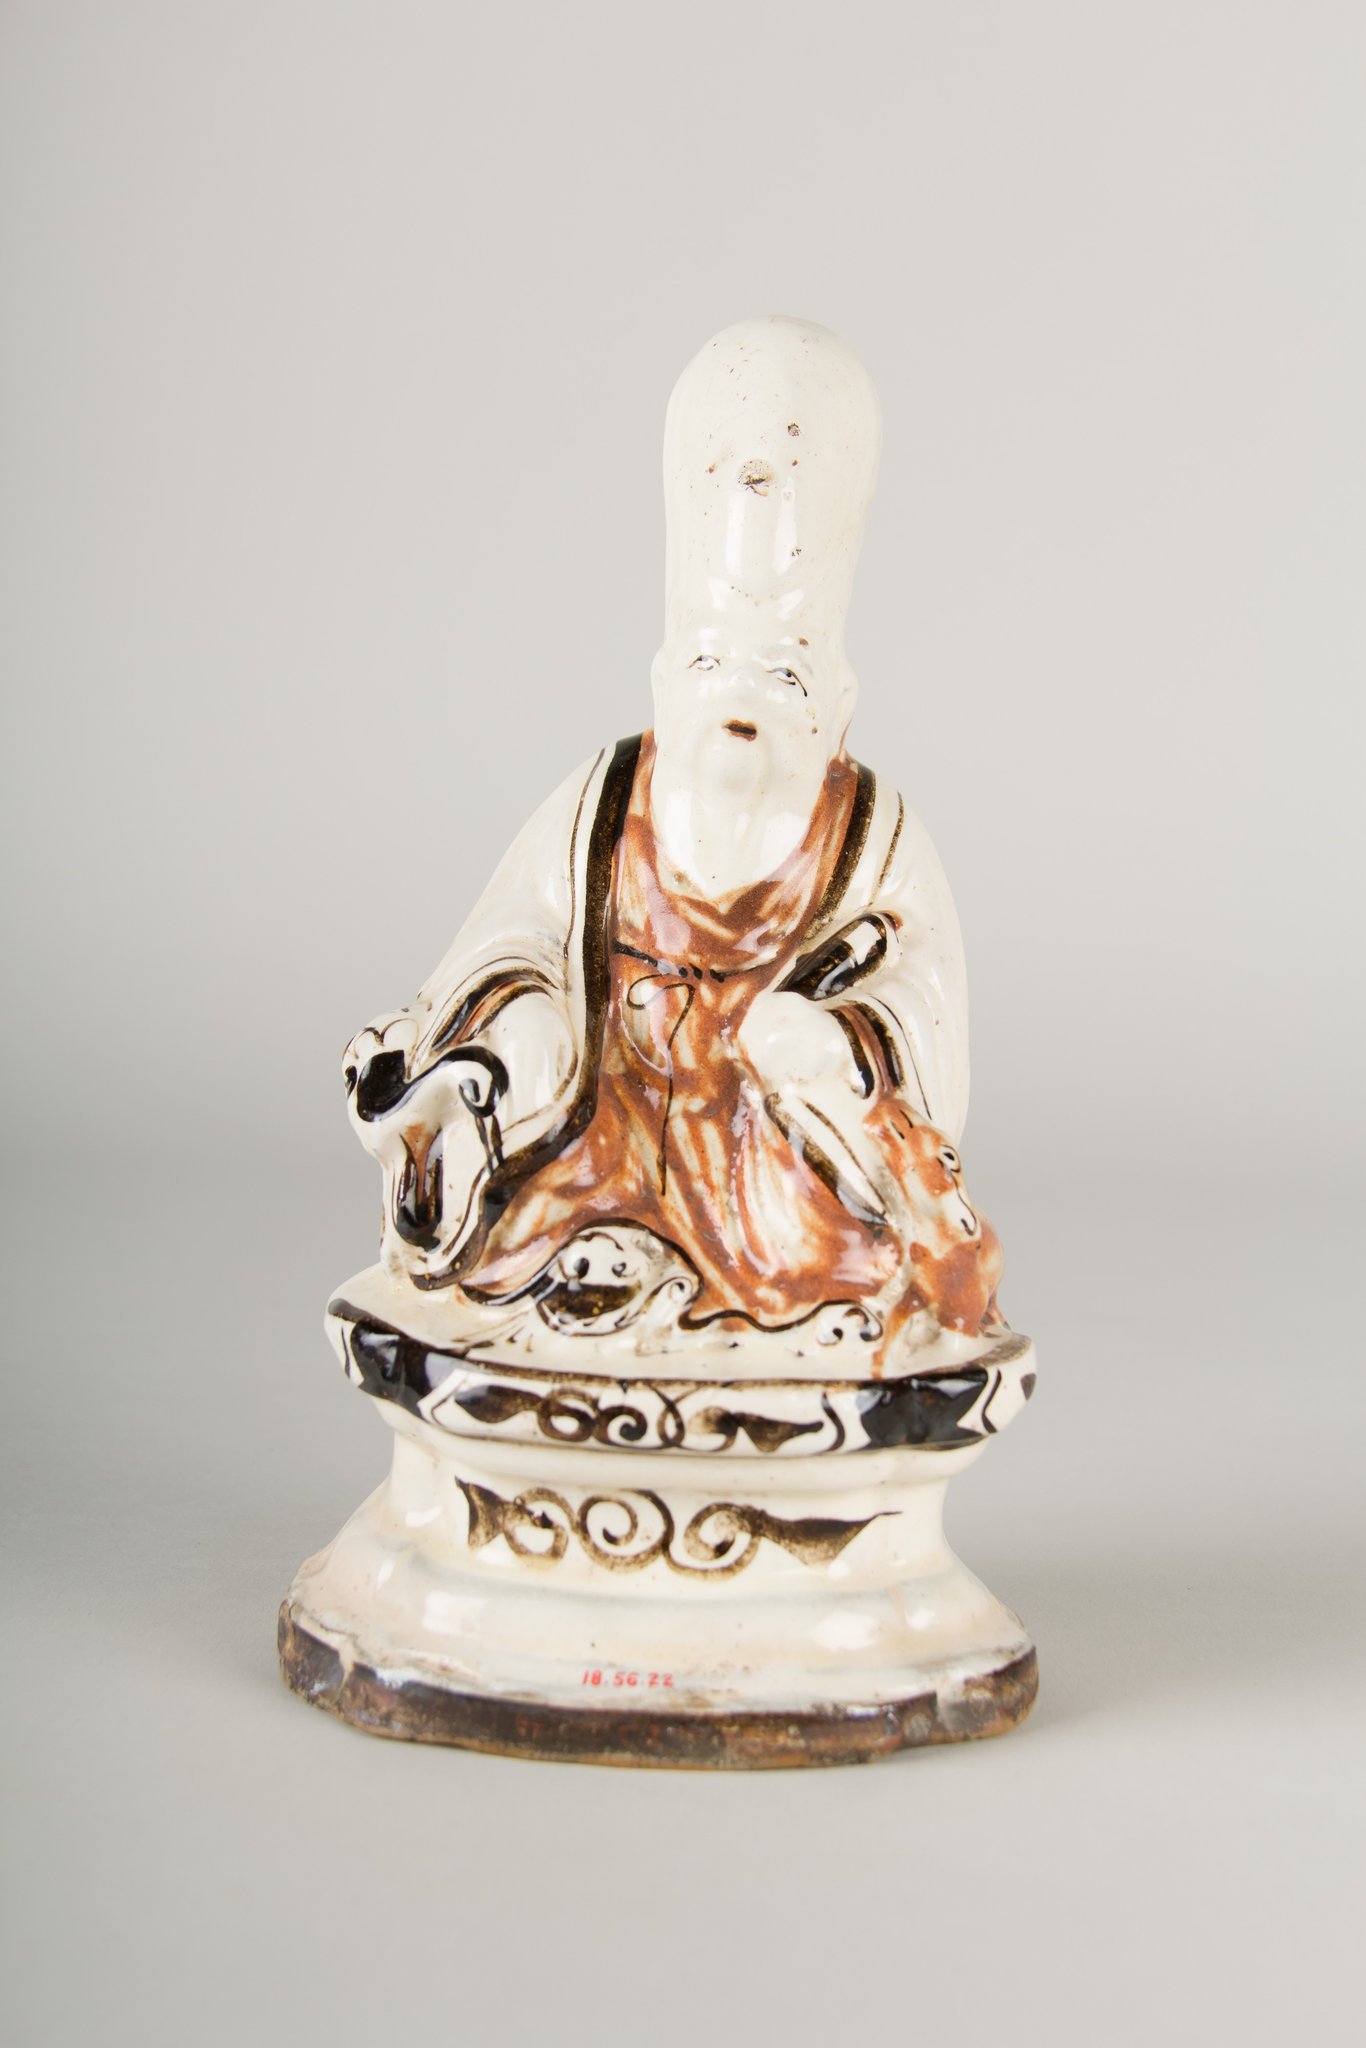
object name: figure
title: Figure of Shou Lao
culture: chinese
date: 1644-1911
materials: stoneware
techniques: glazing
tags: men